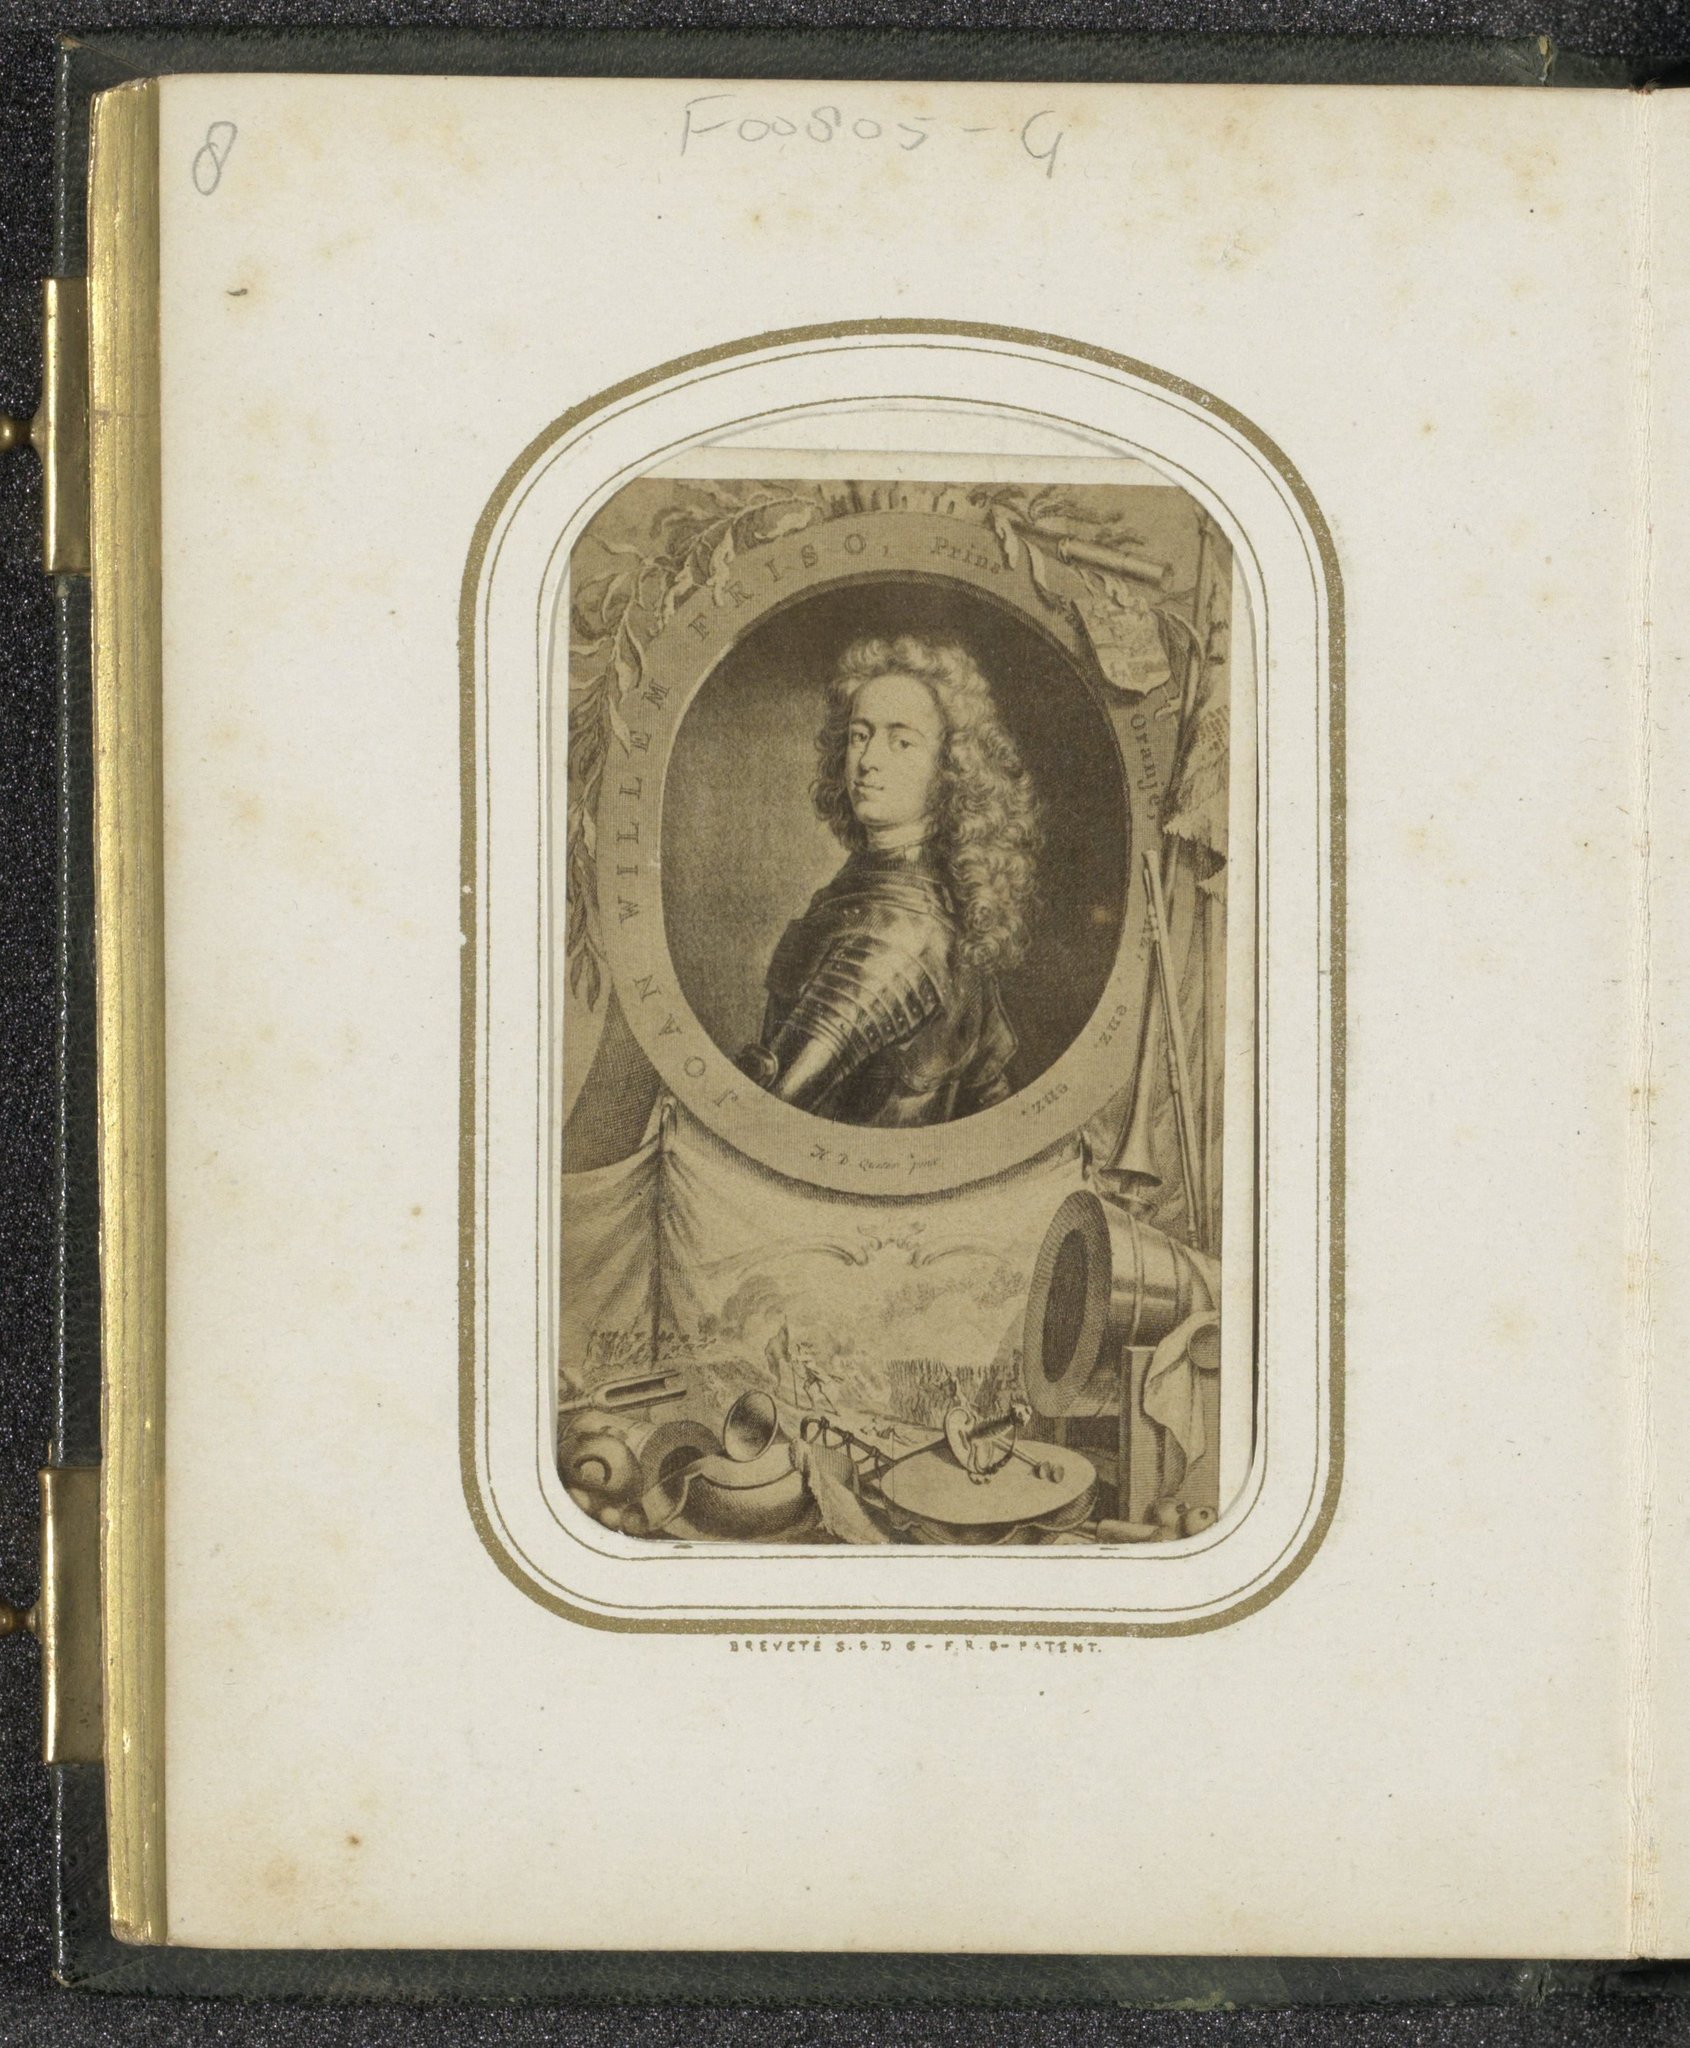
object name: carte de visite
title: Fotoreproductie van (vermoedelijk) een prent van Johan Willem Friso, prins van Oranje-Nassau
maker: Anonymous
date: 1860-1880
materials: cardboard, paper, photographic support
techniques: albumen print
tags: johan willem friso (prins van oranje-nassau), prince, harness, historical persons, hairdress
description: Onderdeel van Fotoalbum met 29 foto's van Nederlandse vorsten.